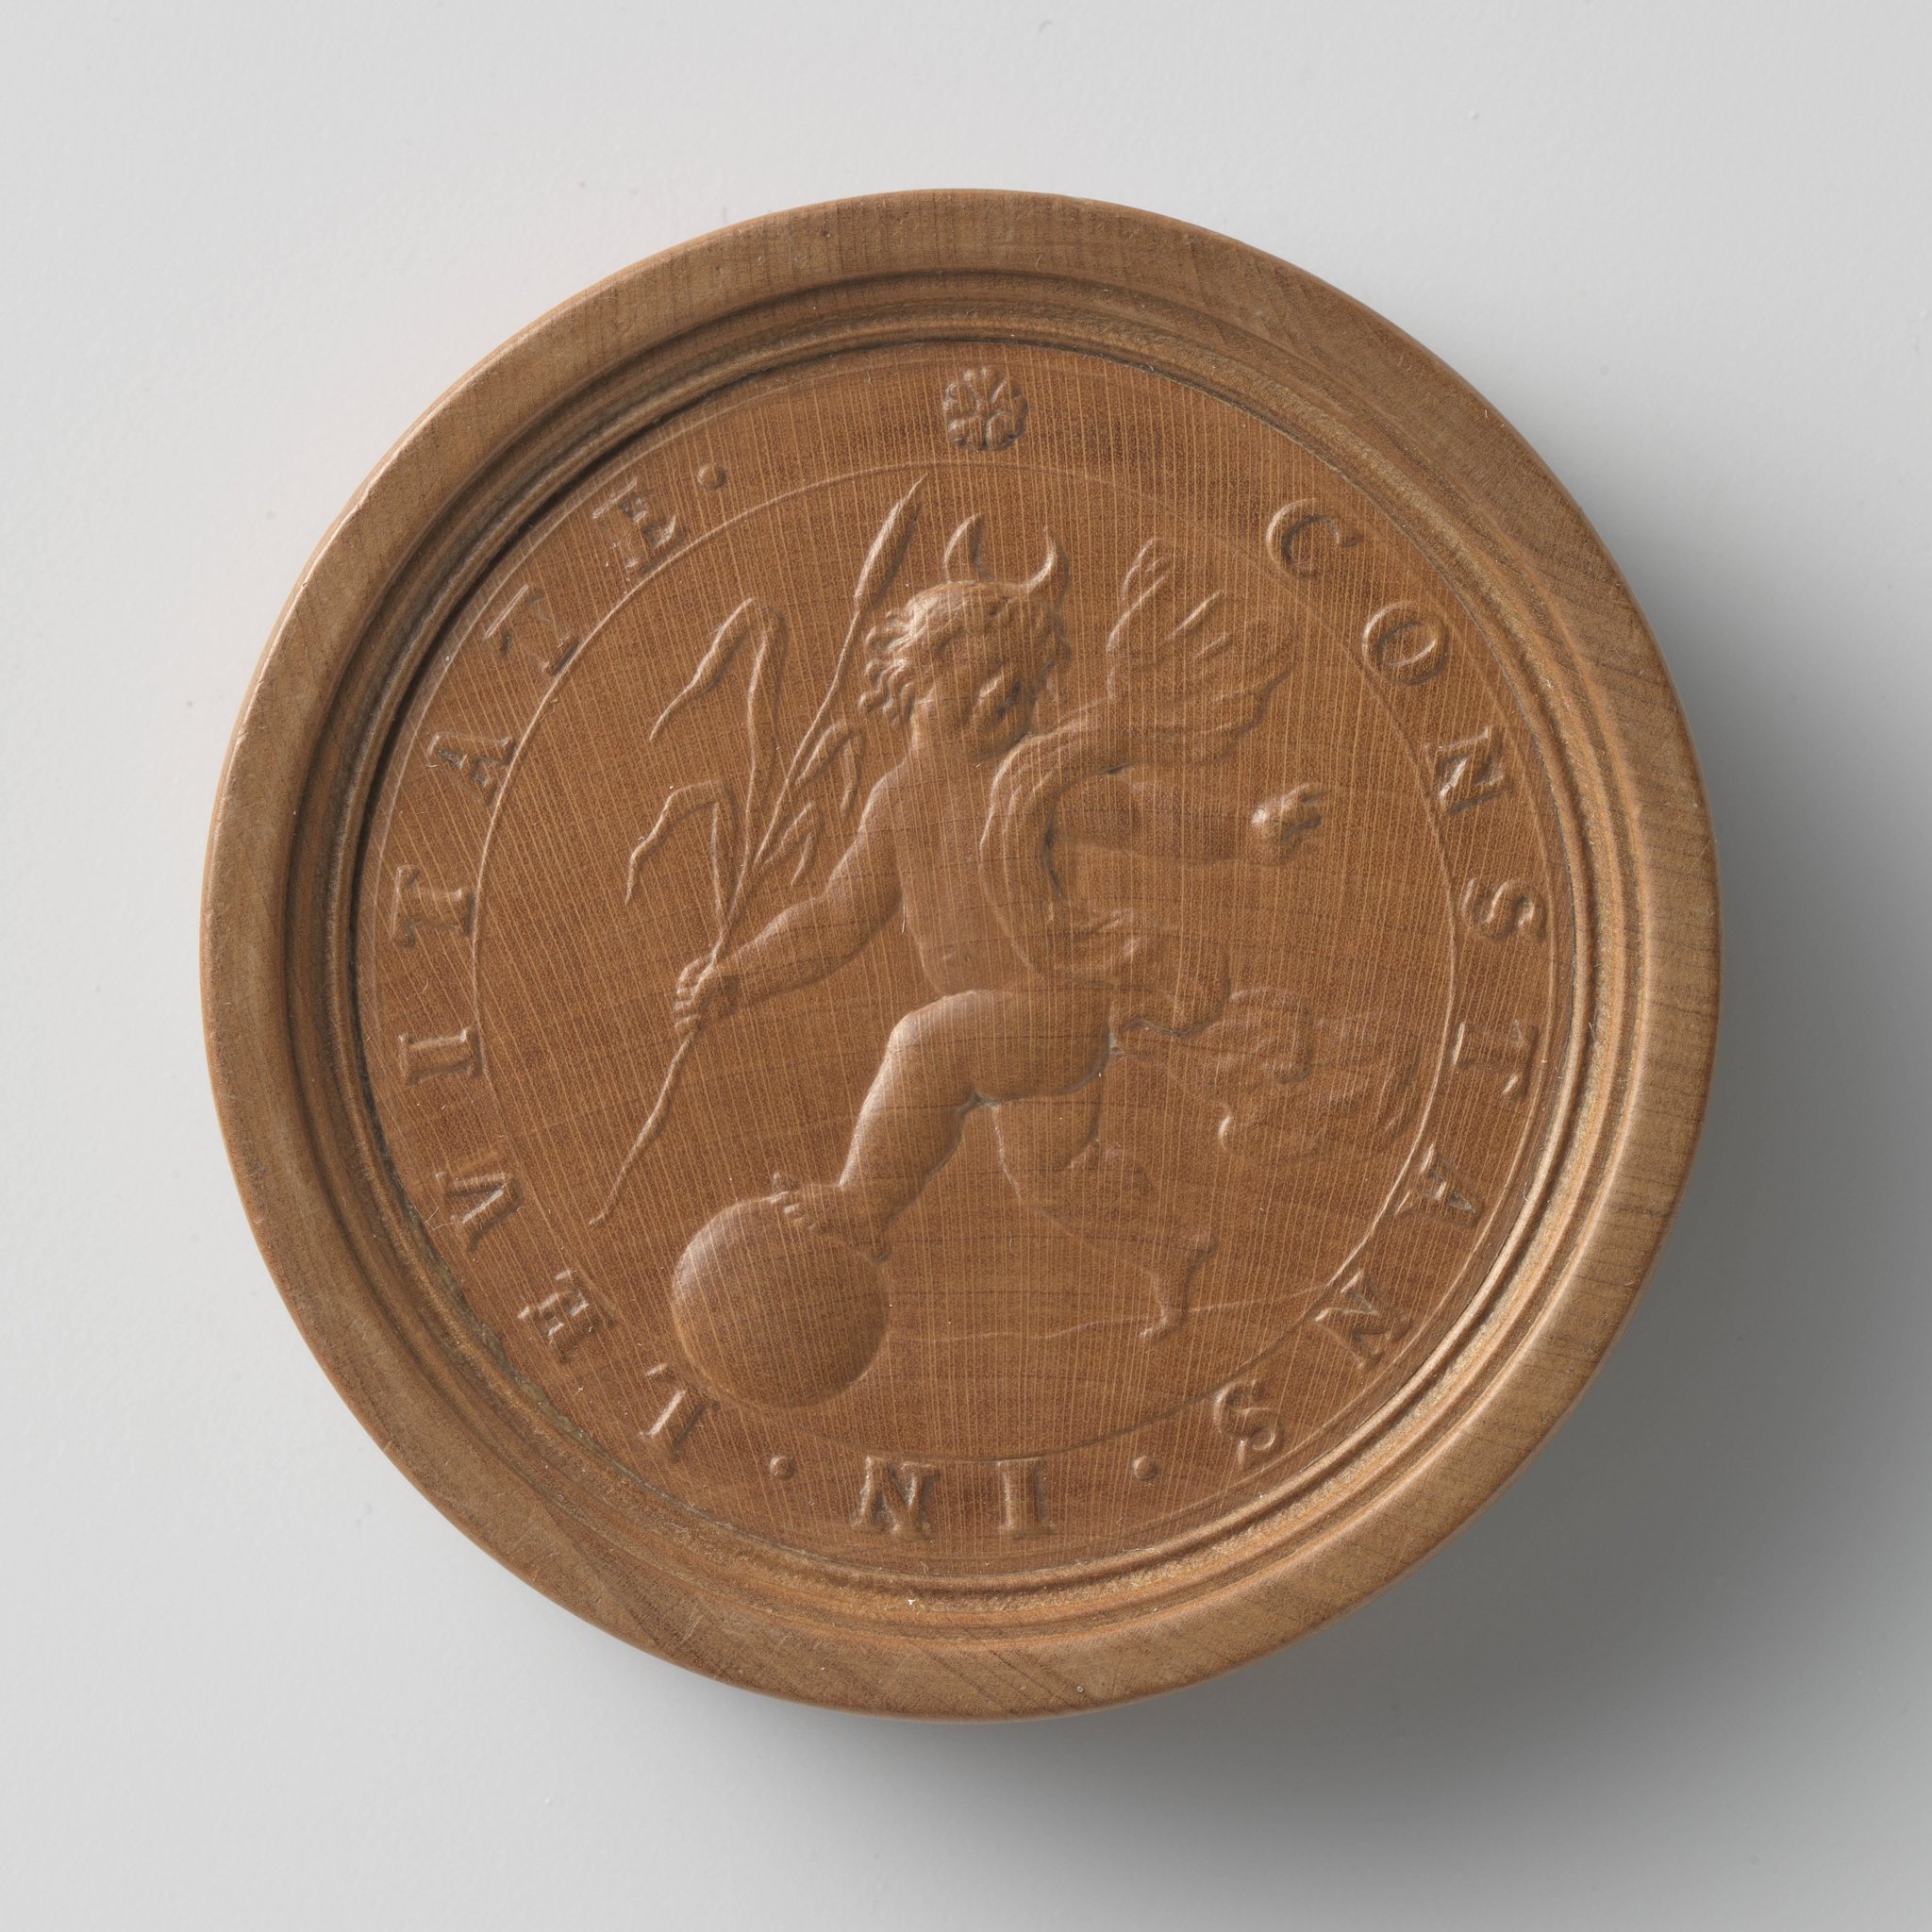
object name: sculpture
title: Damschijf met voorstelling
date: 1675-1700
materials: wood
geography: germany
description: Opschrift PER CASVS.AD.PASSVS' en 'CONSTANS.IN.LEVITATE'. Afbeeldingen van een vallende schaatser en een sater met een korenaar in de hand.